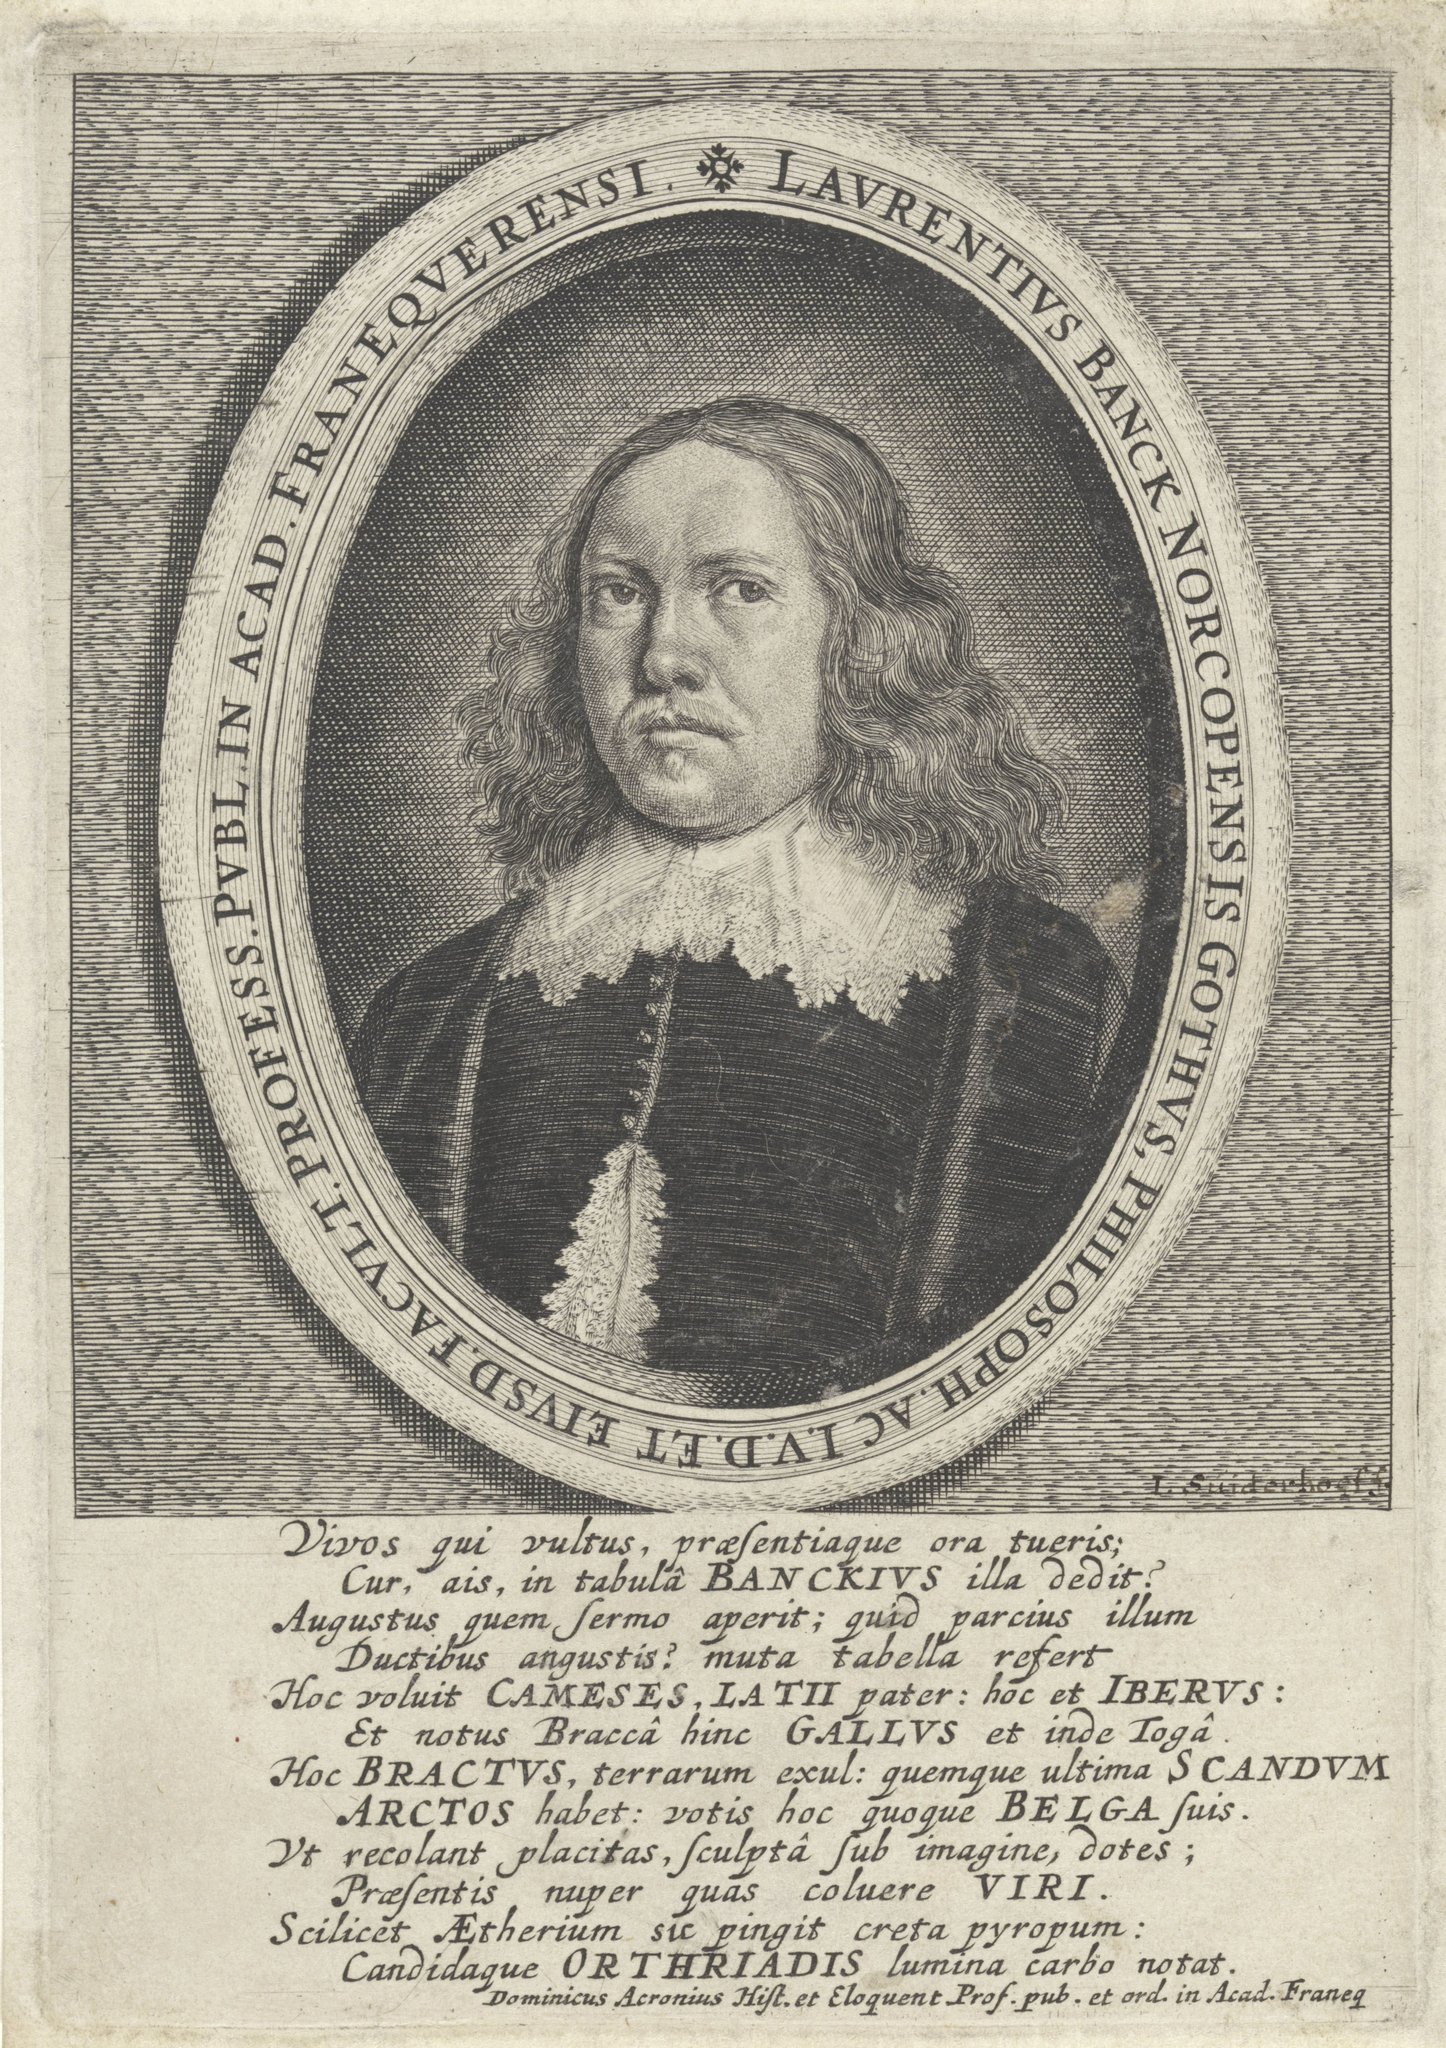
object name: print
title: Portret van Laurens Banck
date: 1623-1686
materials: paper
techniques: engraving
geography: haarlem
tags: lawyer, attorney at law, professor (+ portrait of teacher, professor)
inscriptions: edge inscription:, collector's mark: Lugt 2228, poem:, signature: ‘Dominicus Acronius Hist. et Eloquent Prof. pub. et ord. in Acad. Franeq’, signature: ‘I. Suijderhoef s.’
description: Portret van Laurens Banck, hoogleraar in de rechten aan de universiteit van Franeker. Onder het portret een twaalfregelig vers in het Latijn.